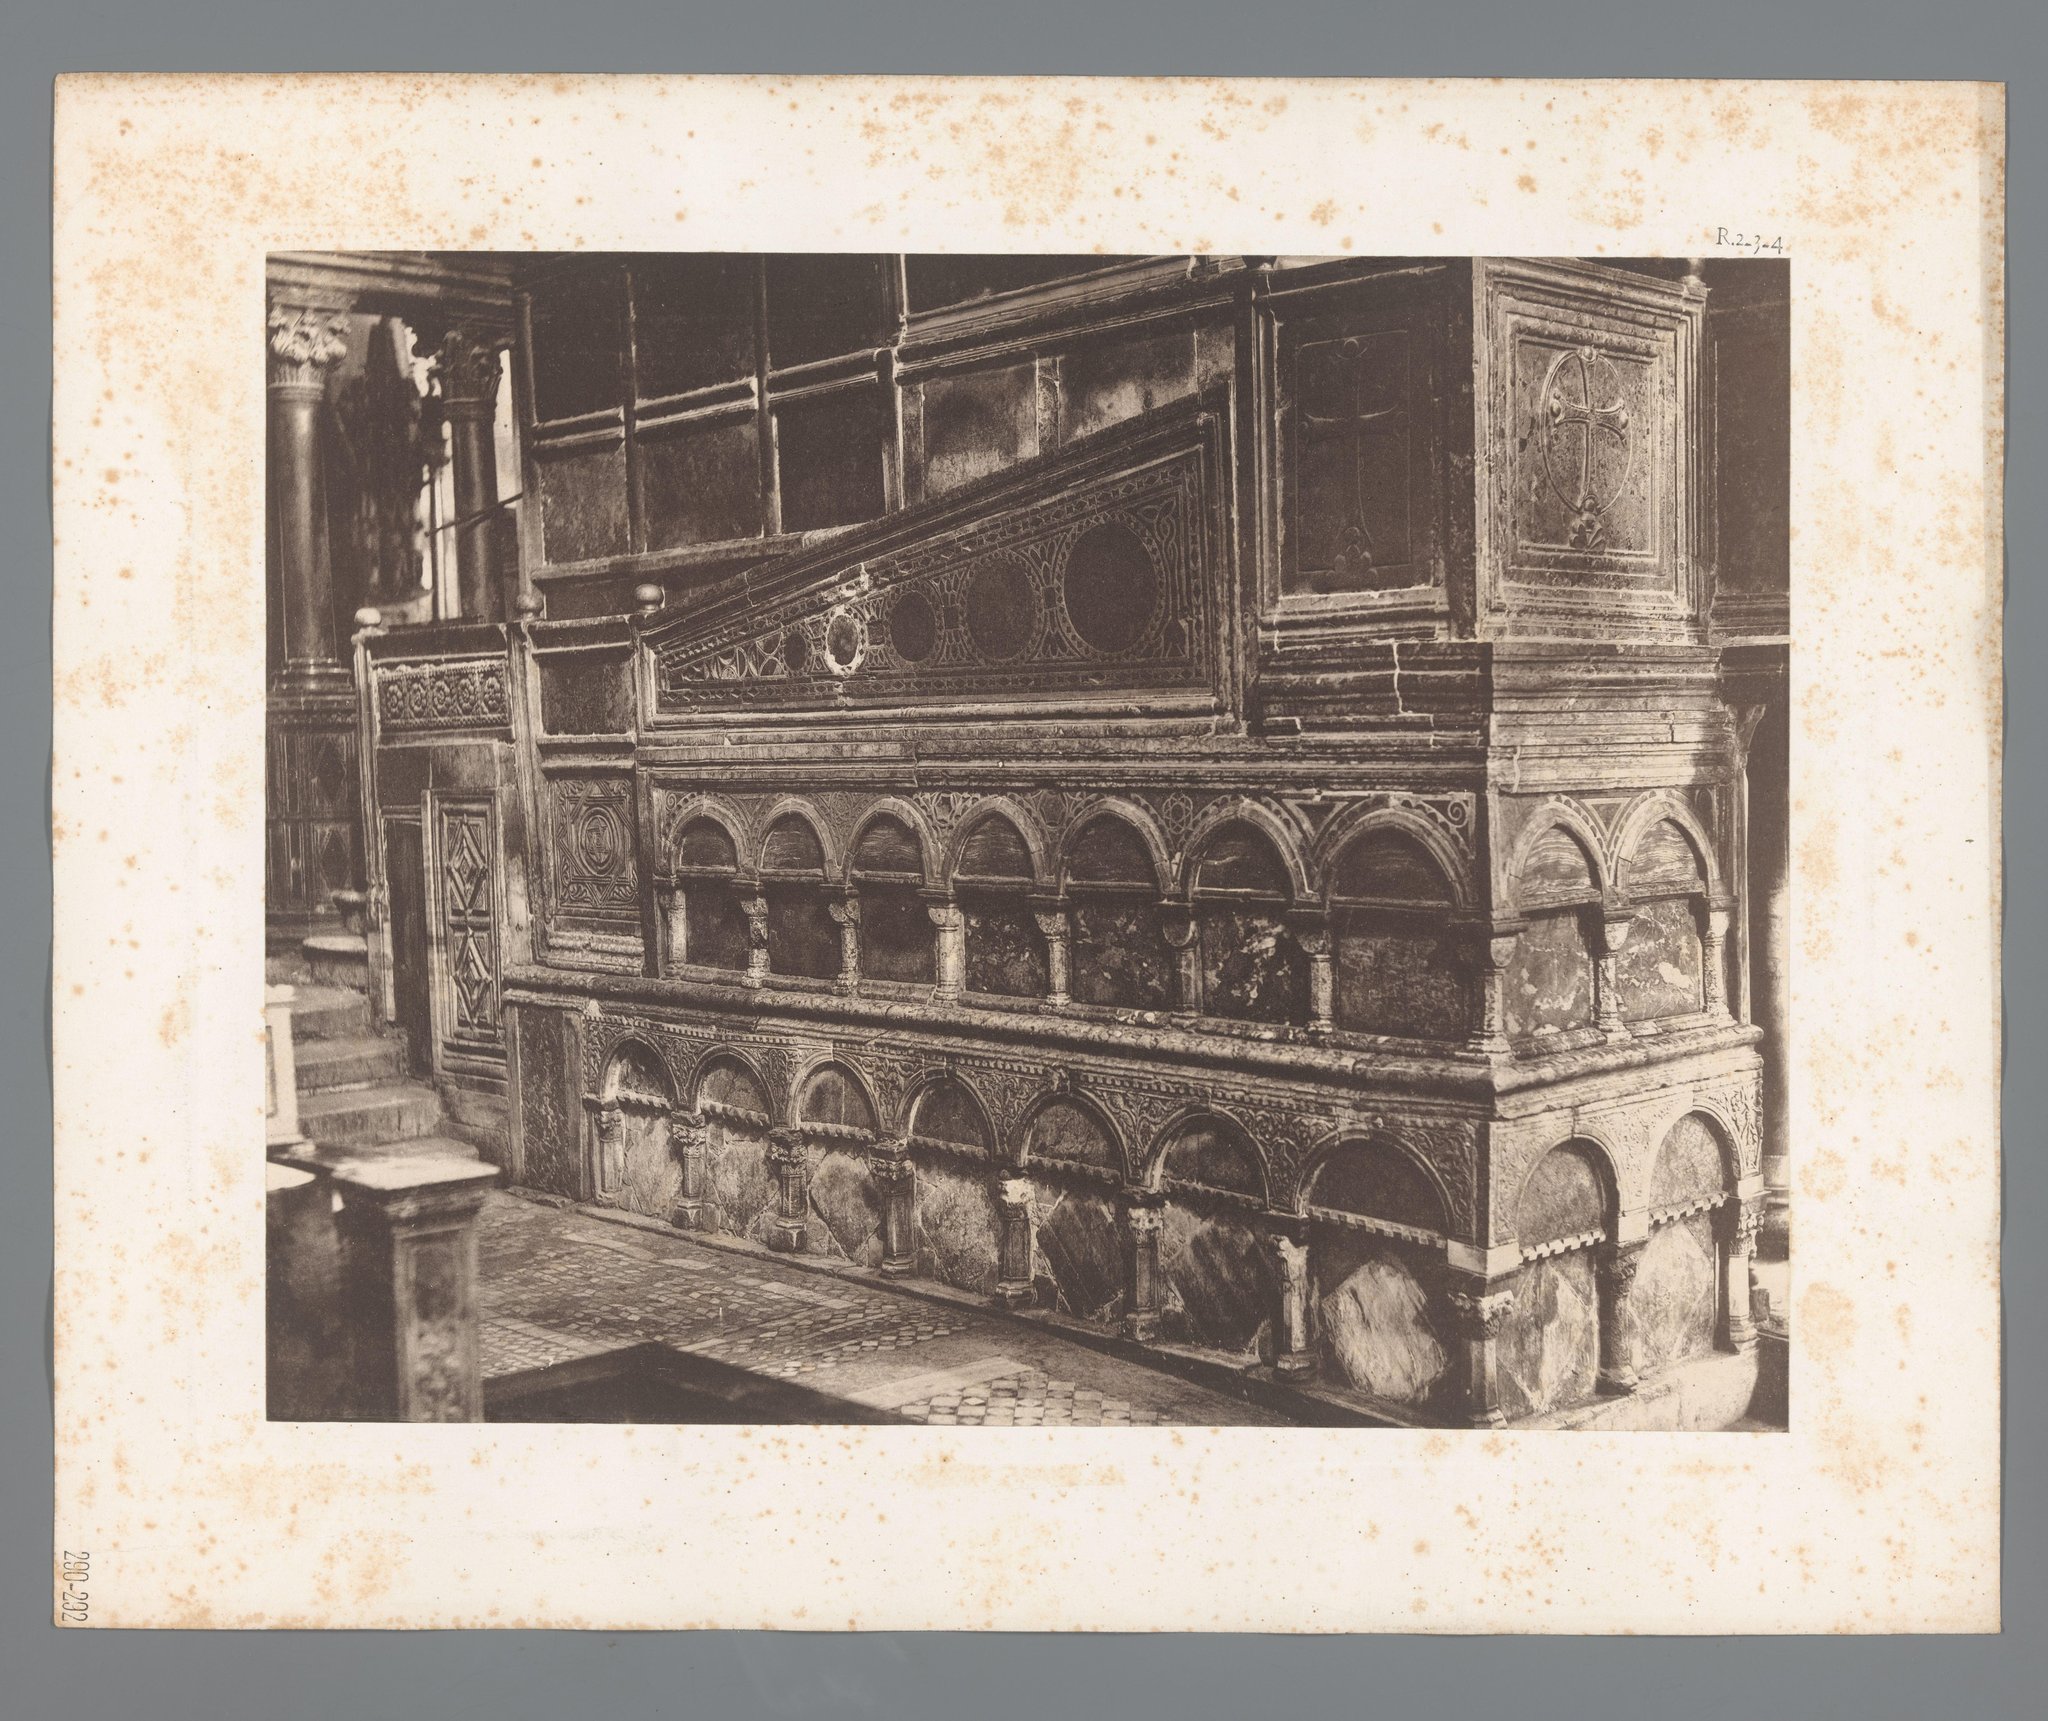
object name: photomechanical print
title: Ombouw van een kansel in de San Marco in Venetië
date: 1880-1885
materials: paper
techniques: photograph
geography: st. mark's basilica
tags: pulpit, ambo, chancel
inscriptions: number: ‘R.2.3.4’, number: ‘290-292’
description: Deze prent maakt deel uit van een omslag met 58 prenten op 50 bladen.